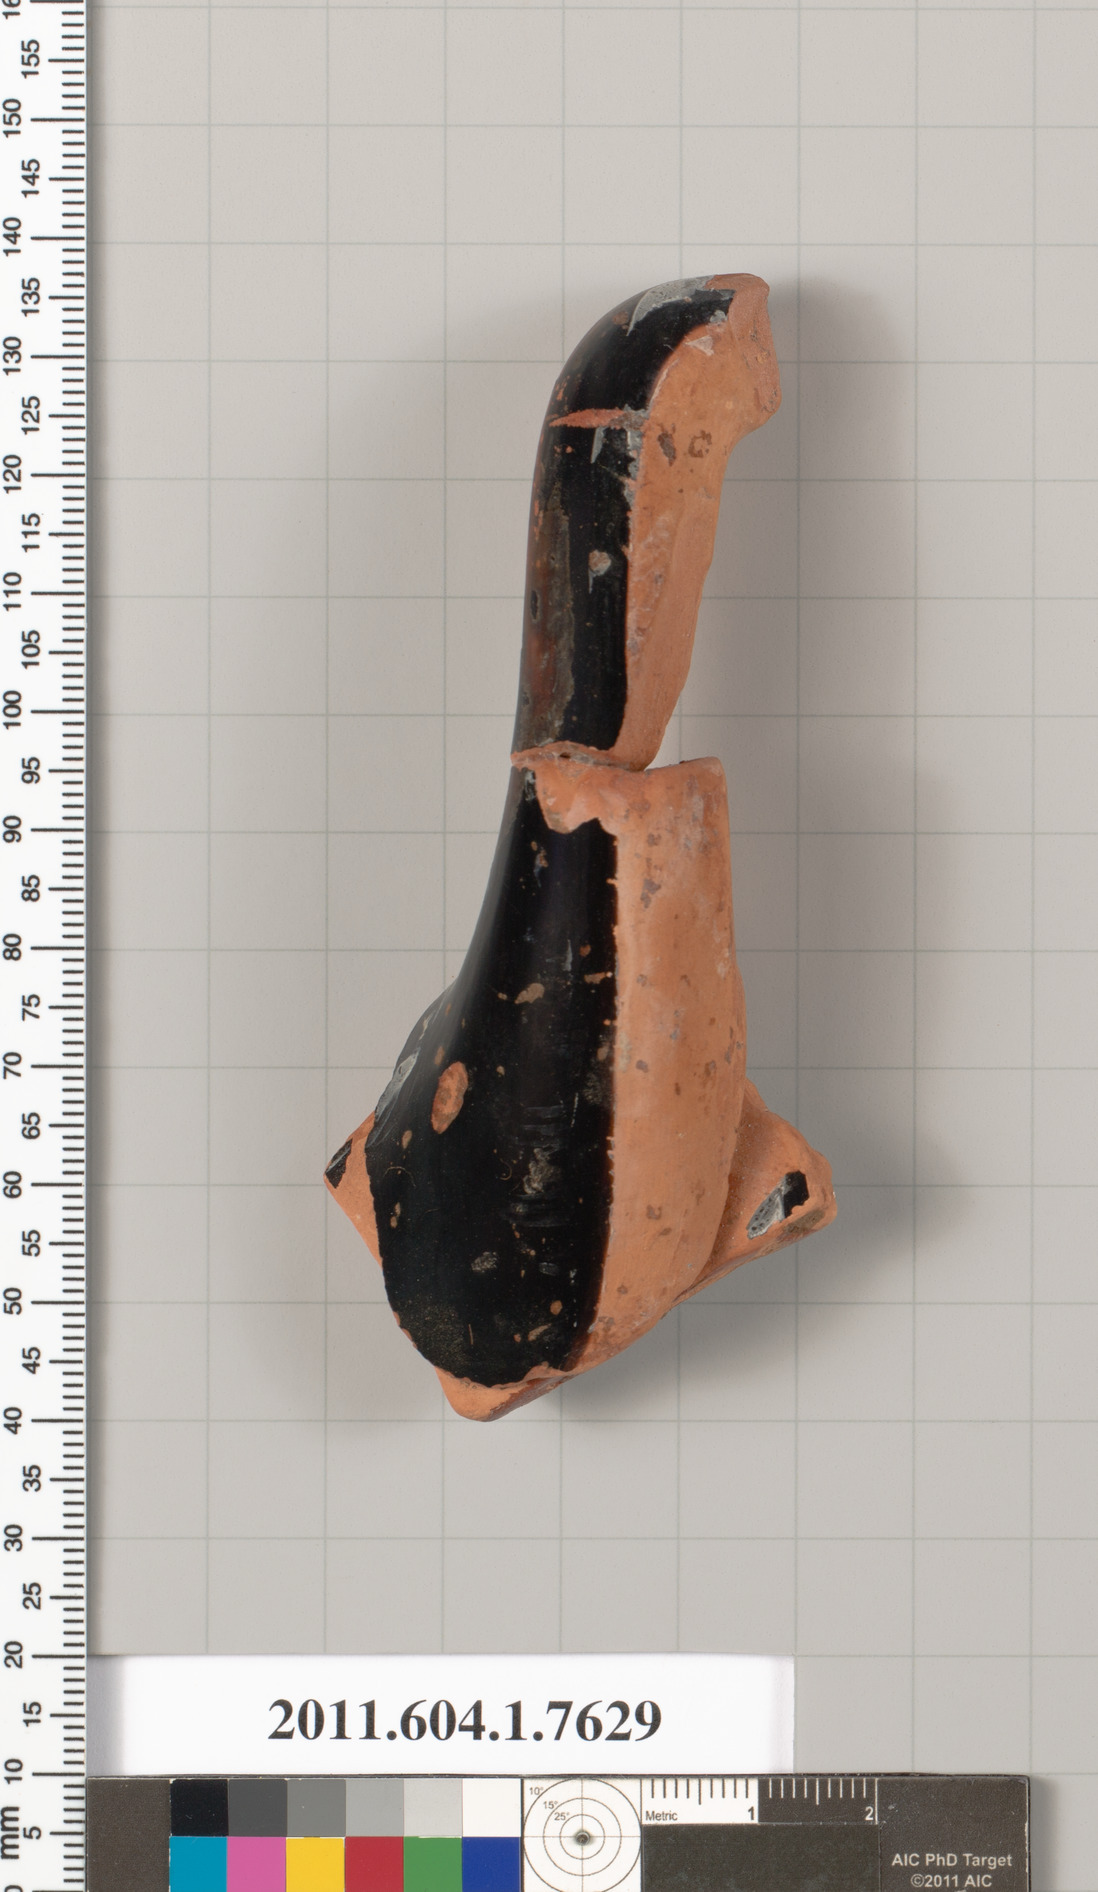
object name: kylix fragment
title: Terracotta fragment of a kylix (drinking cup)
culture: greek, attic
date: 460-450 BCE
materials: terracotta